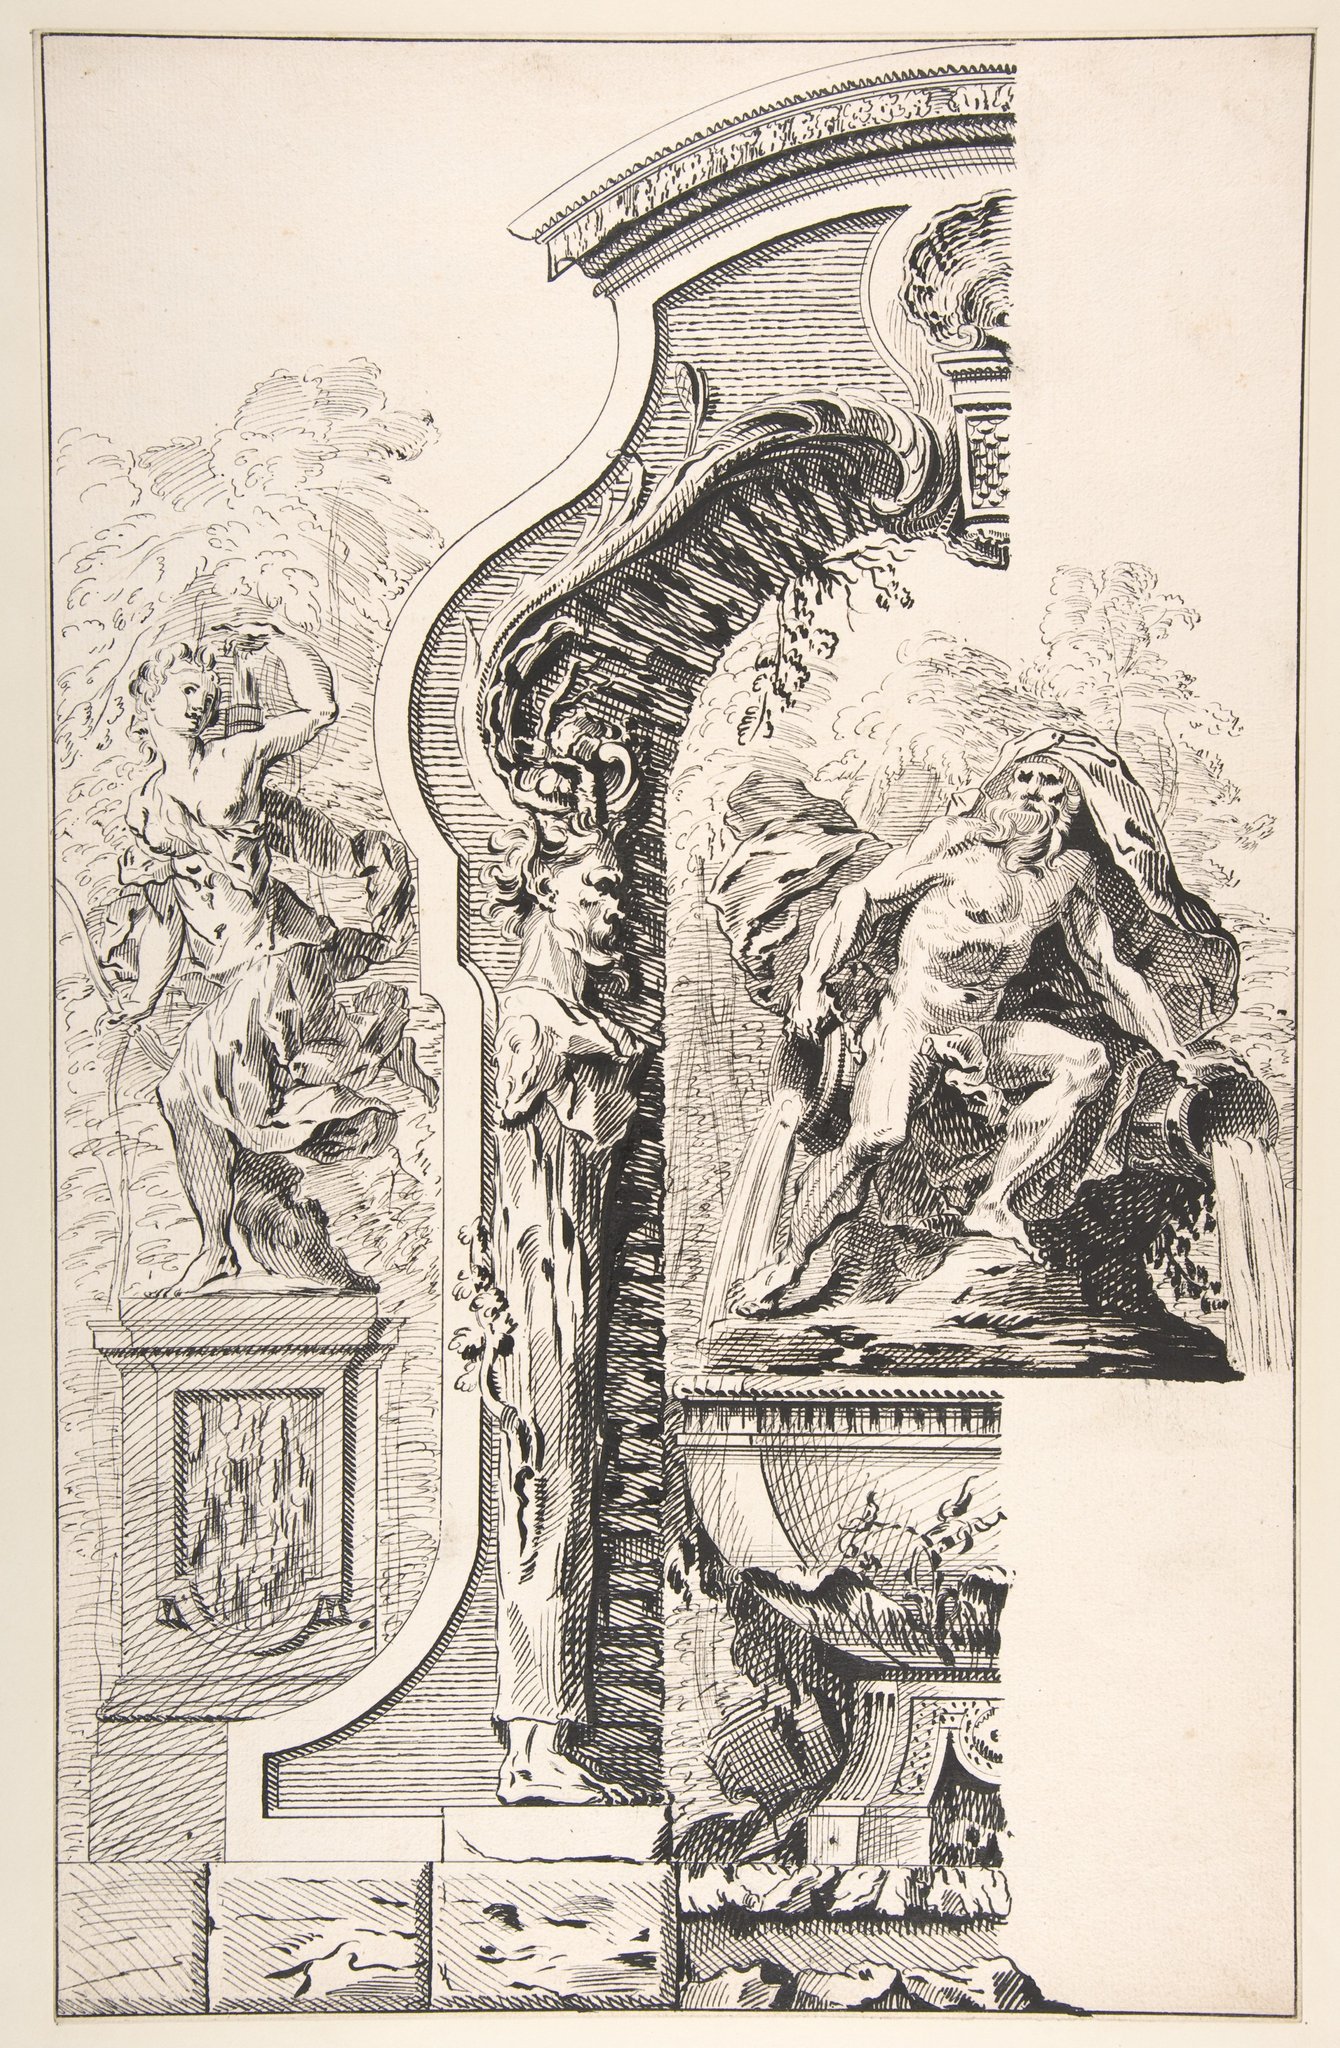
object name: drawing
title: Study for a Garden Capriccio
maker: gilles-marie oppenord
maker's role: artist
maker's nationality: french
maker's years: 1672-1742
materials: graphite, ink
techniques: pen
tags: architecture,gardens,male nudes